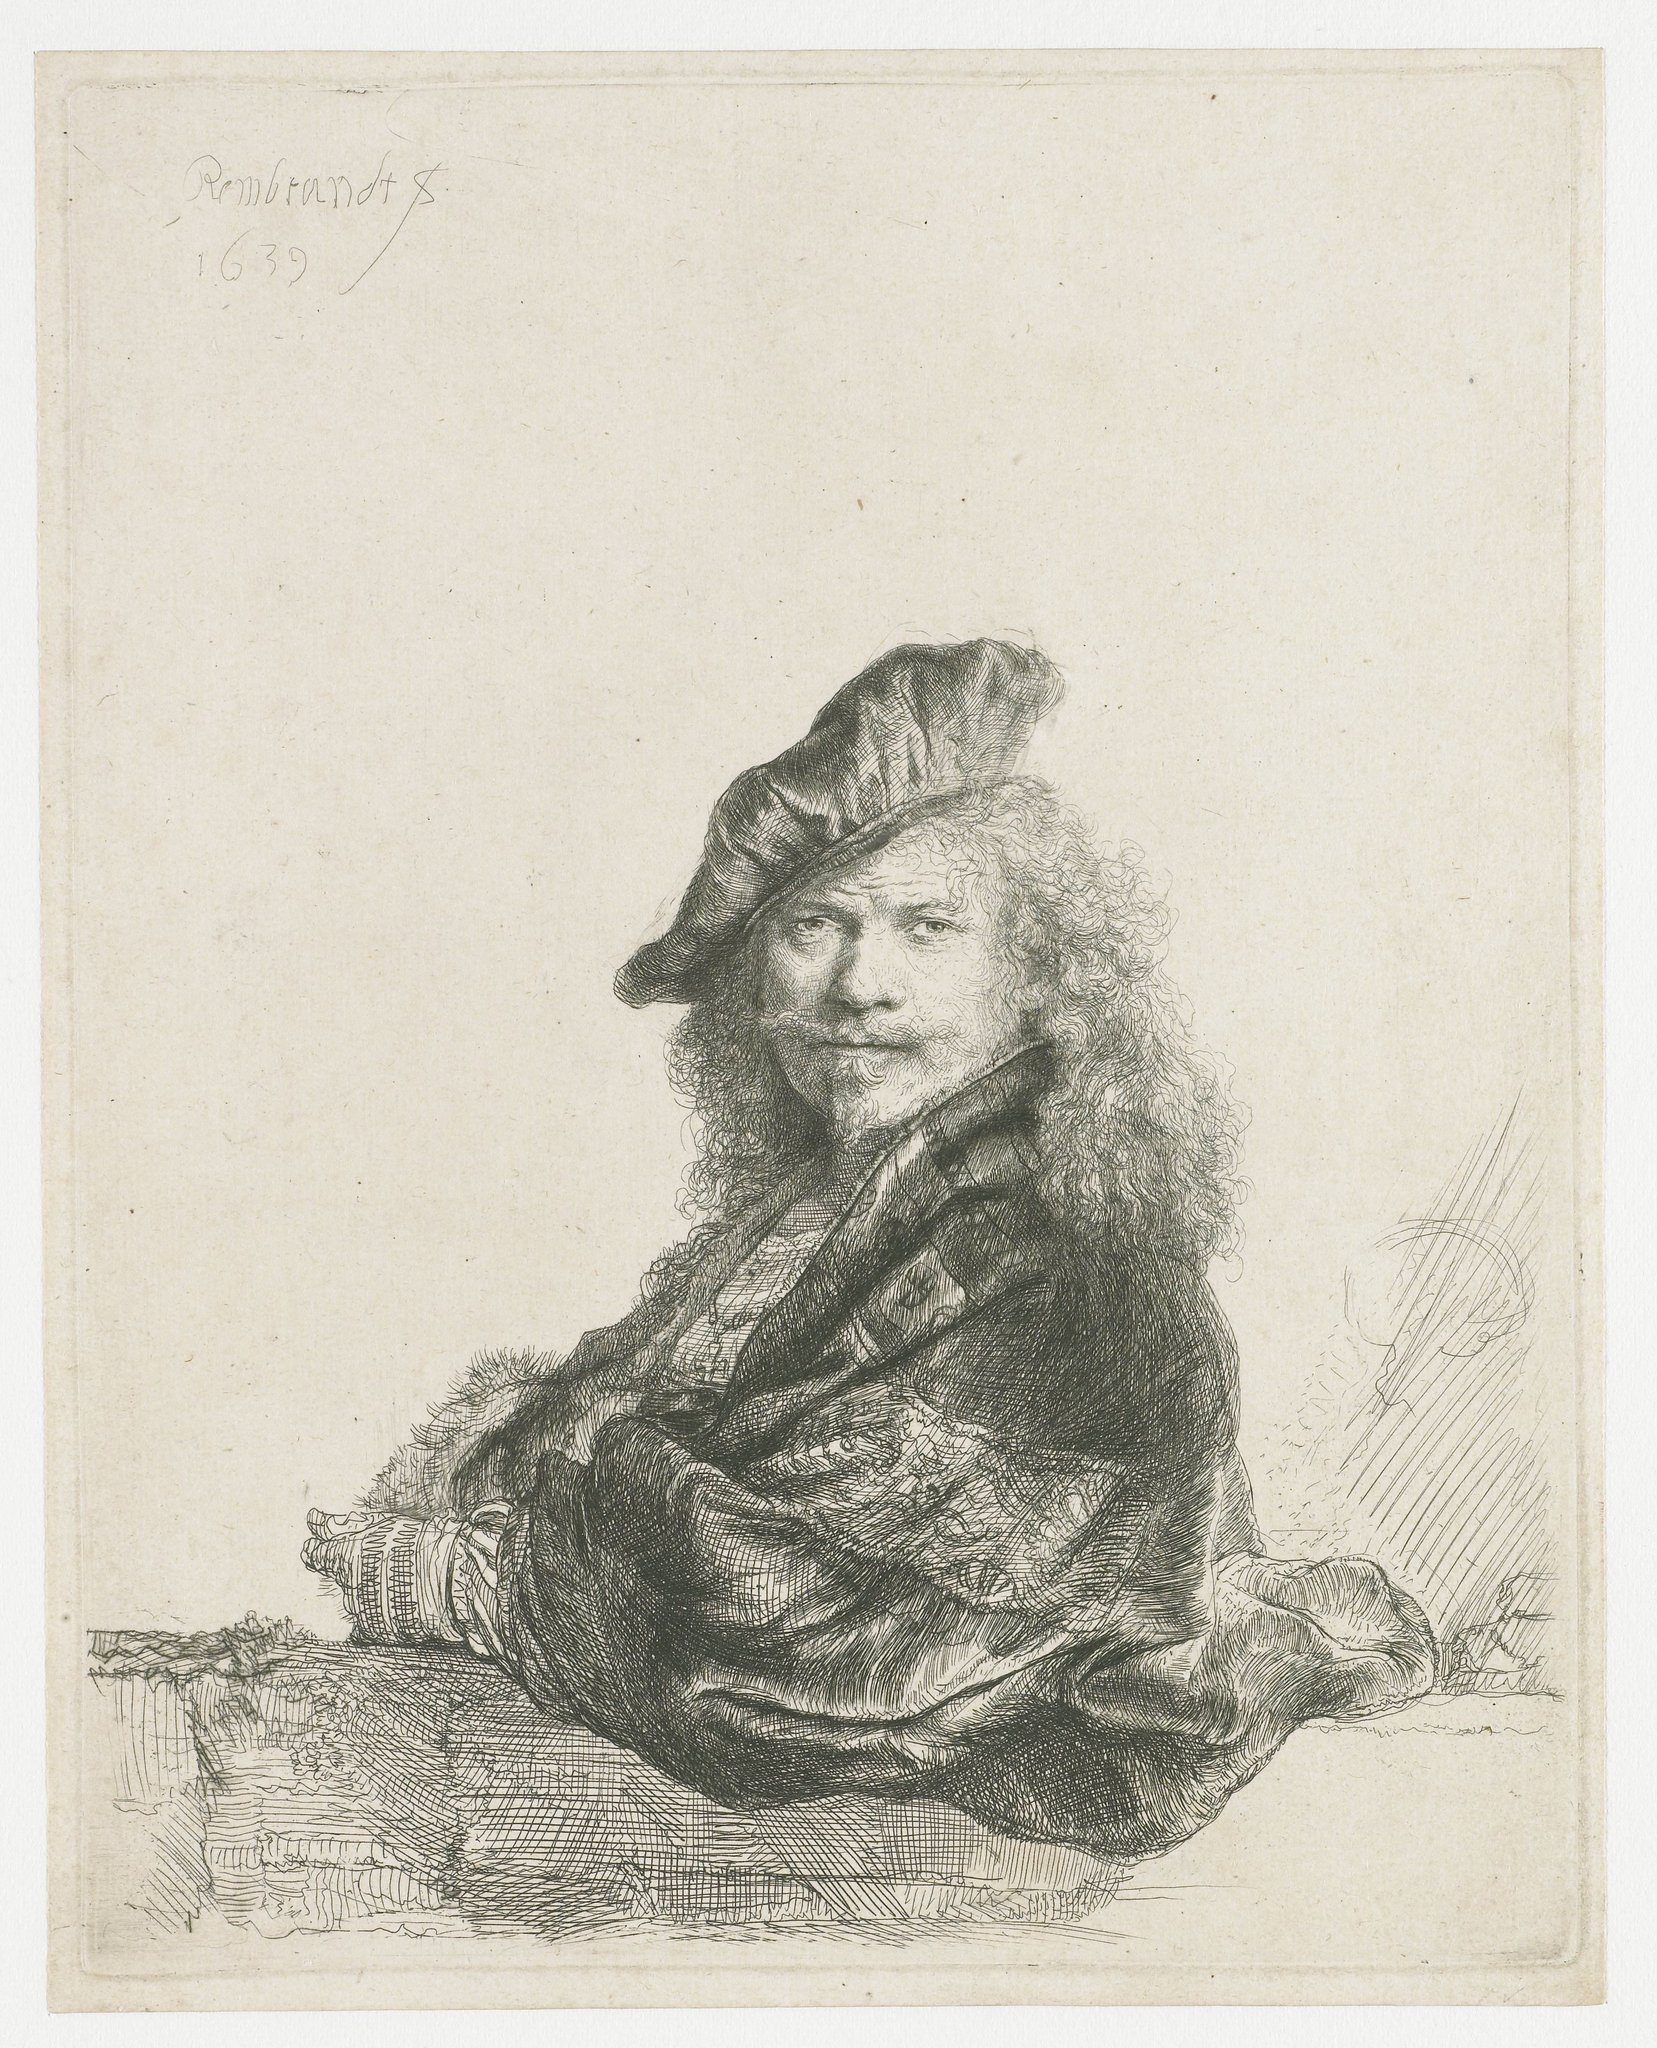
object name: print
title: Self-portrait leaning on a stone sill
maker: rembrandt van rijn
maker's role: draughtsman, painter, print maker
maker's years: 1606-1669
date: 1639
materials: chalk, paper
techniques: etching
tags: leiden, amsterdam, painter, print maker, draughtsman, rembrandt van rijn, portrait, self-portrait of graphic artist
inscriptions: signature and date: ‘Rembrandt f. 1639’